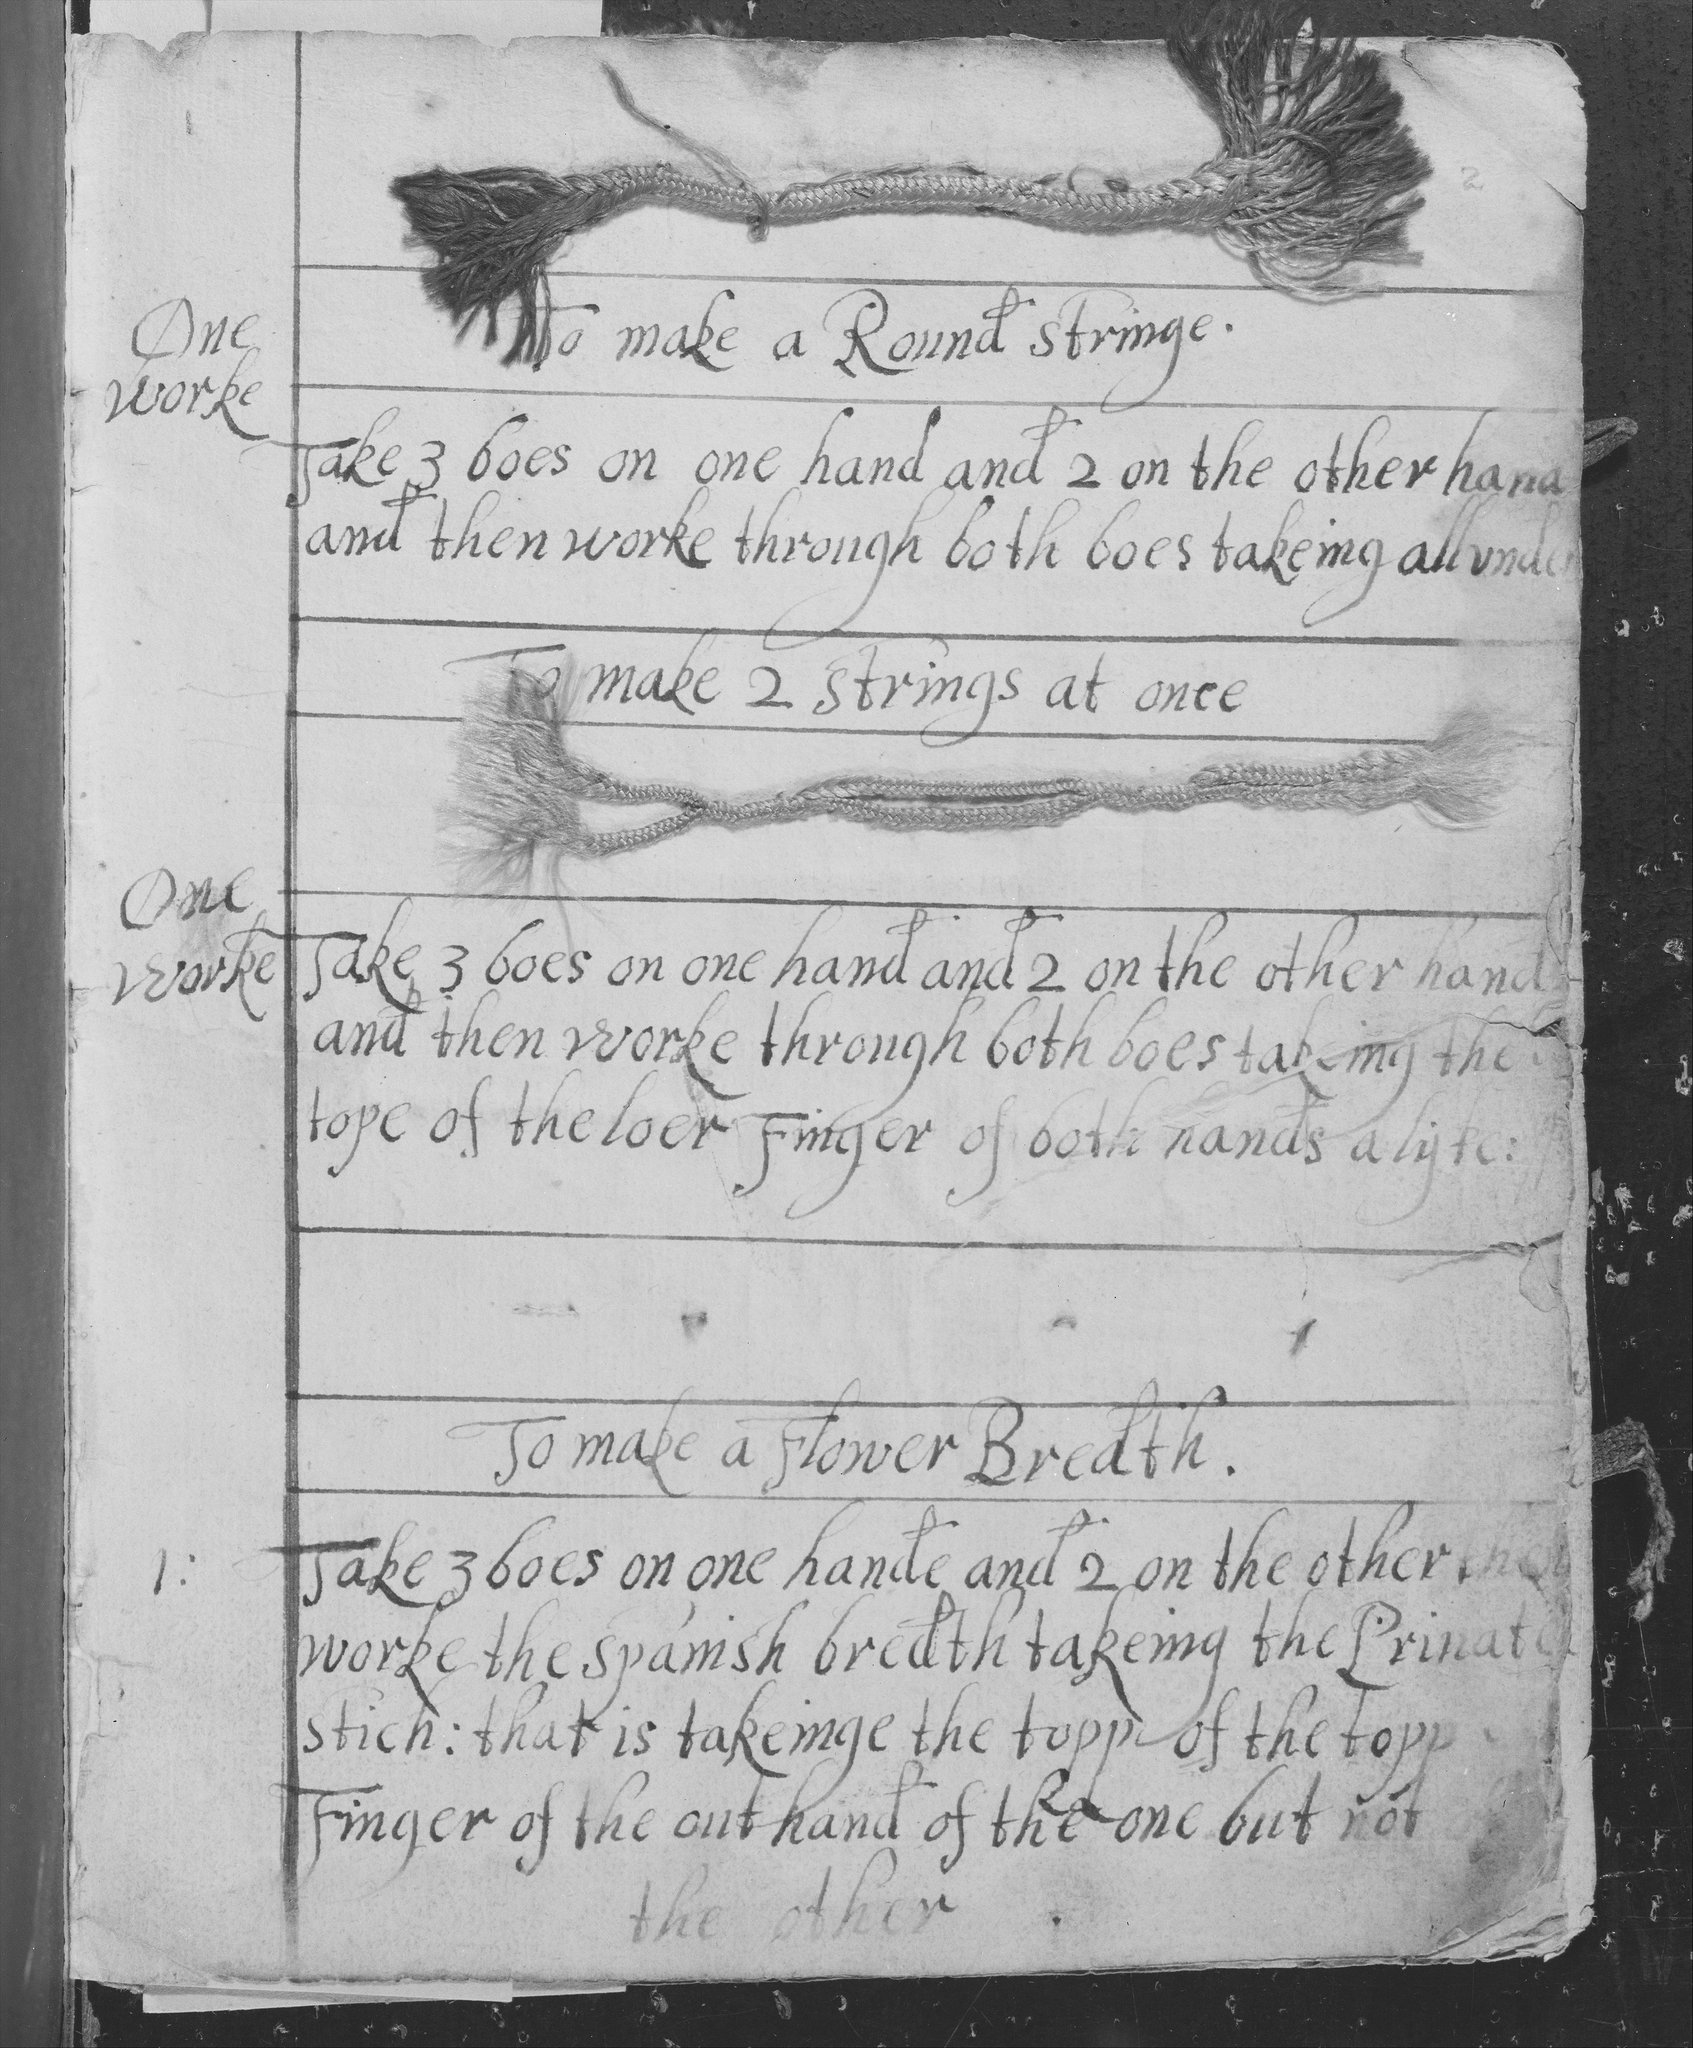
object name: book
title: Manuscript book of patterns for purse strings and braid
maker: lucie glover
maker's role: author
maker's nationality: british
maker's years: 1600-1700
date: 1655